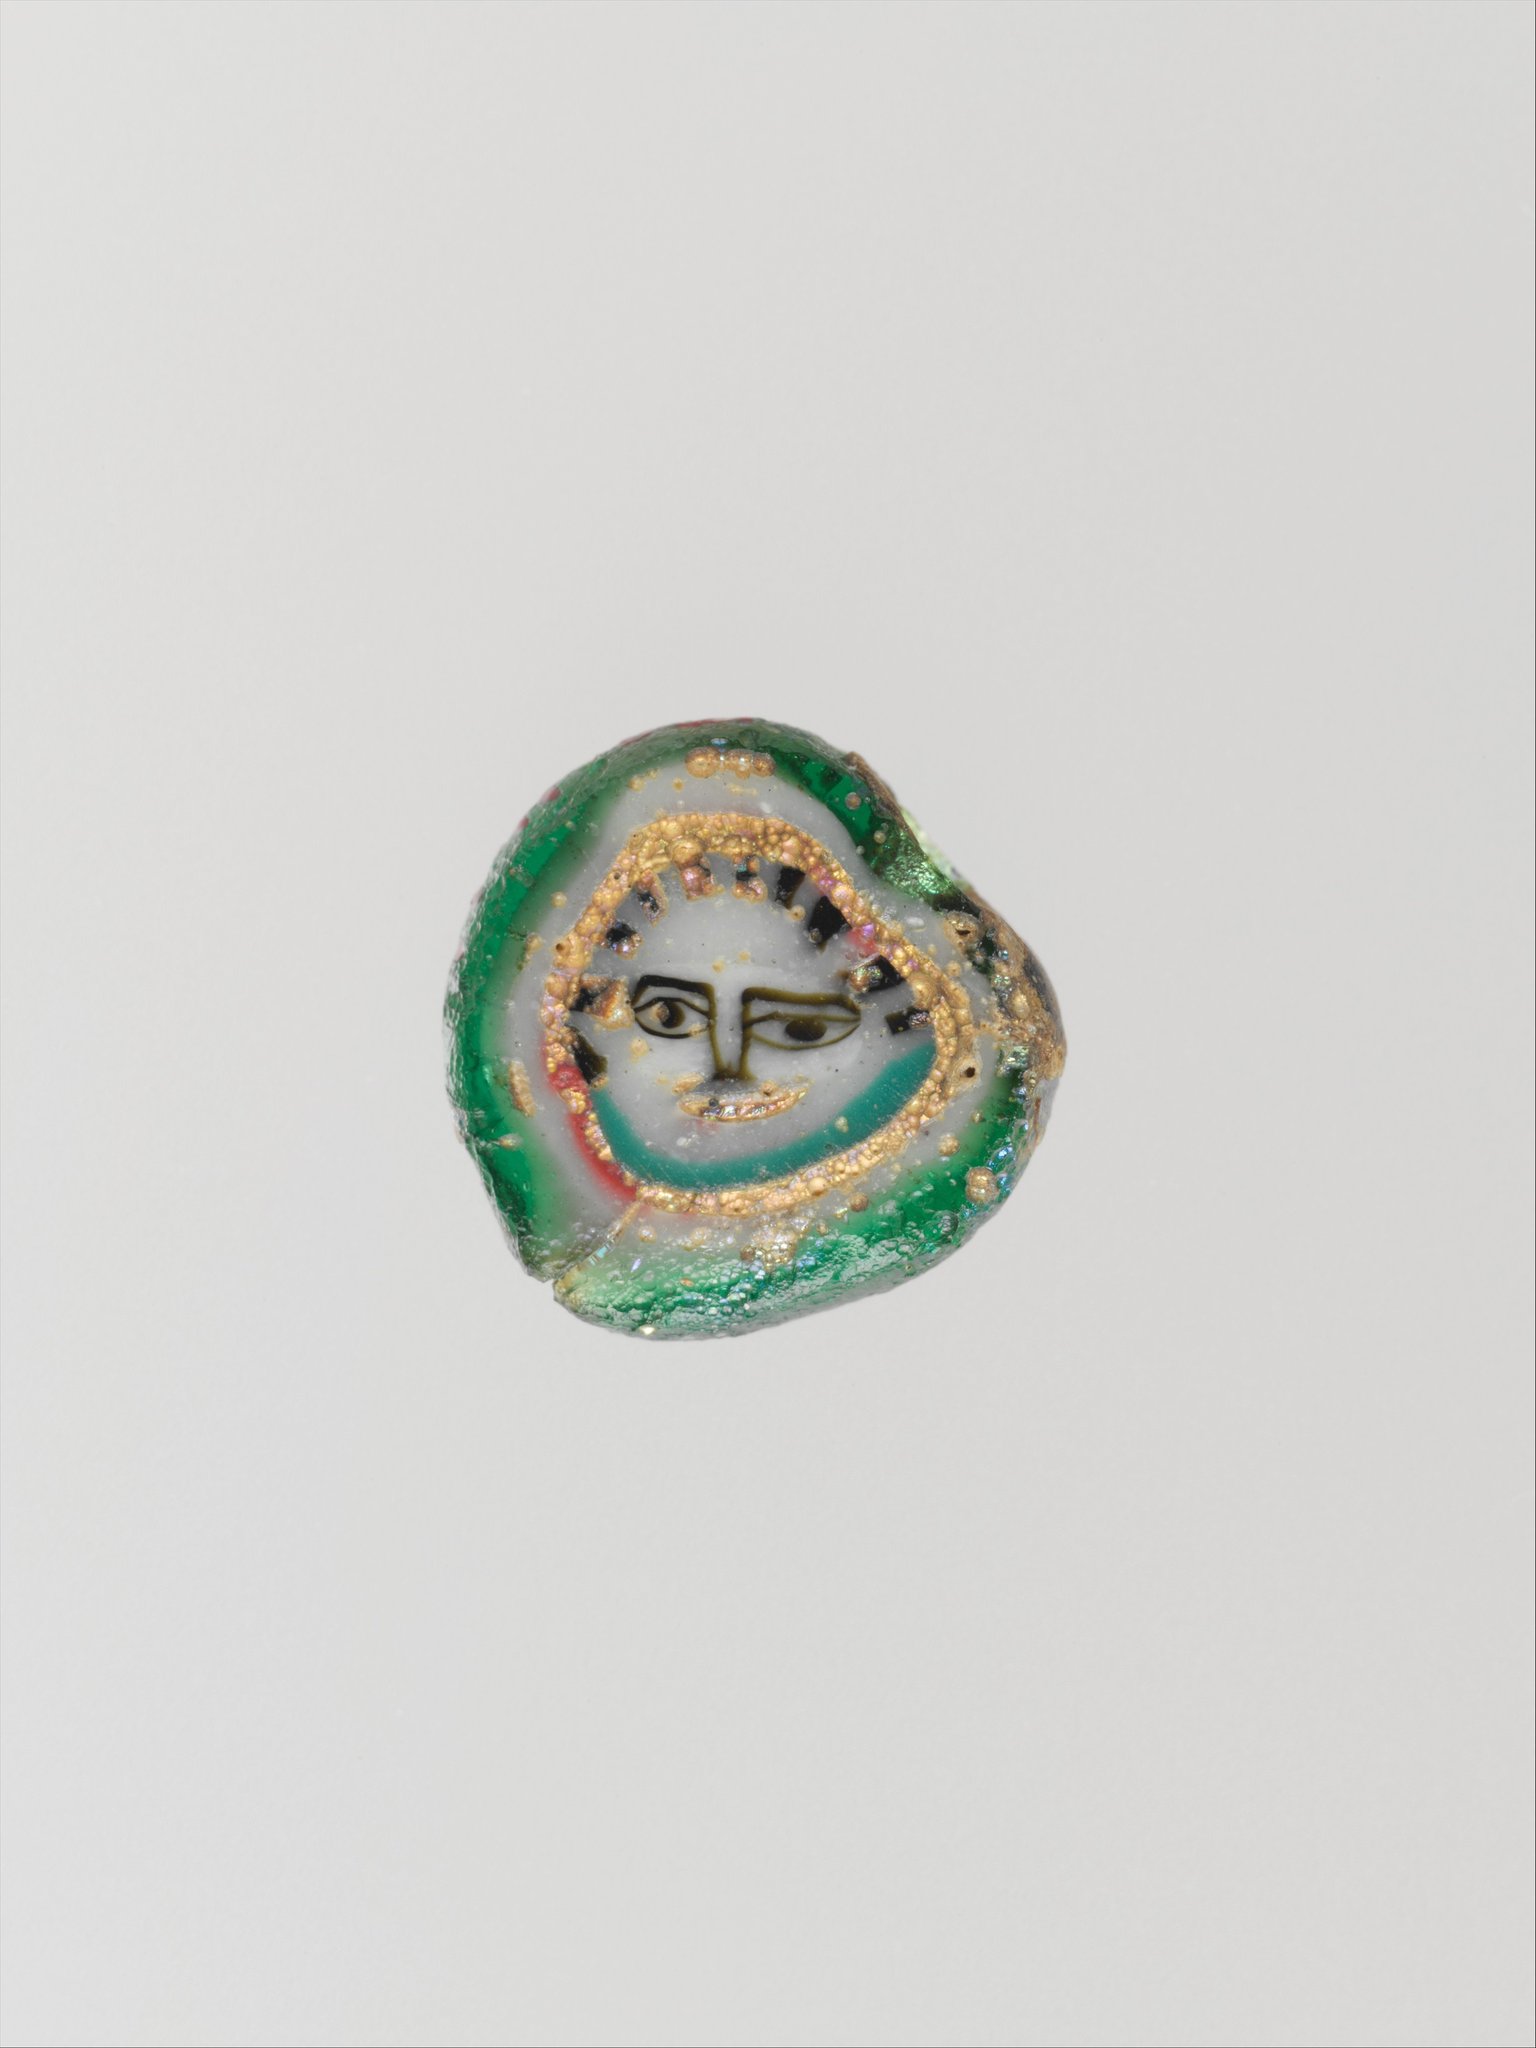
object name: face bead, discoid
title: Glass mosaic face bead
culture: roman, eastern mediterranean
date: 100 BCE-100 CE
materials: glass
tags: faces